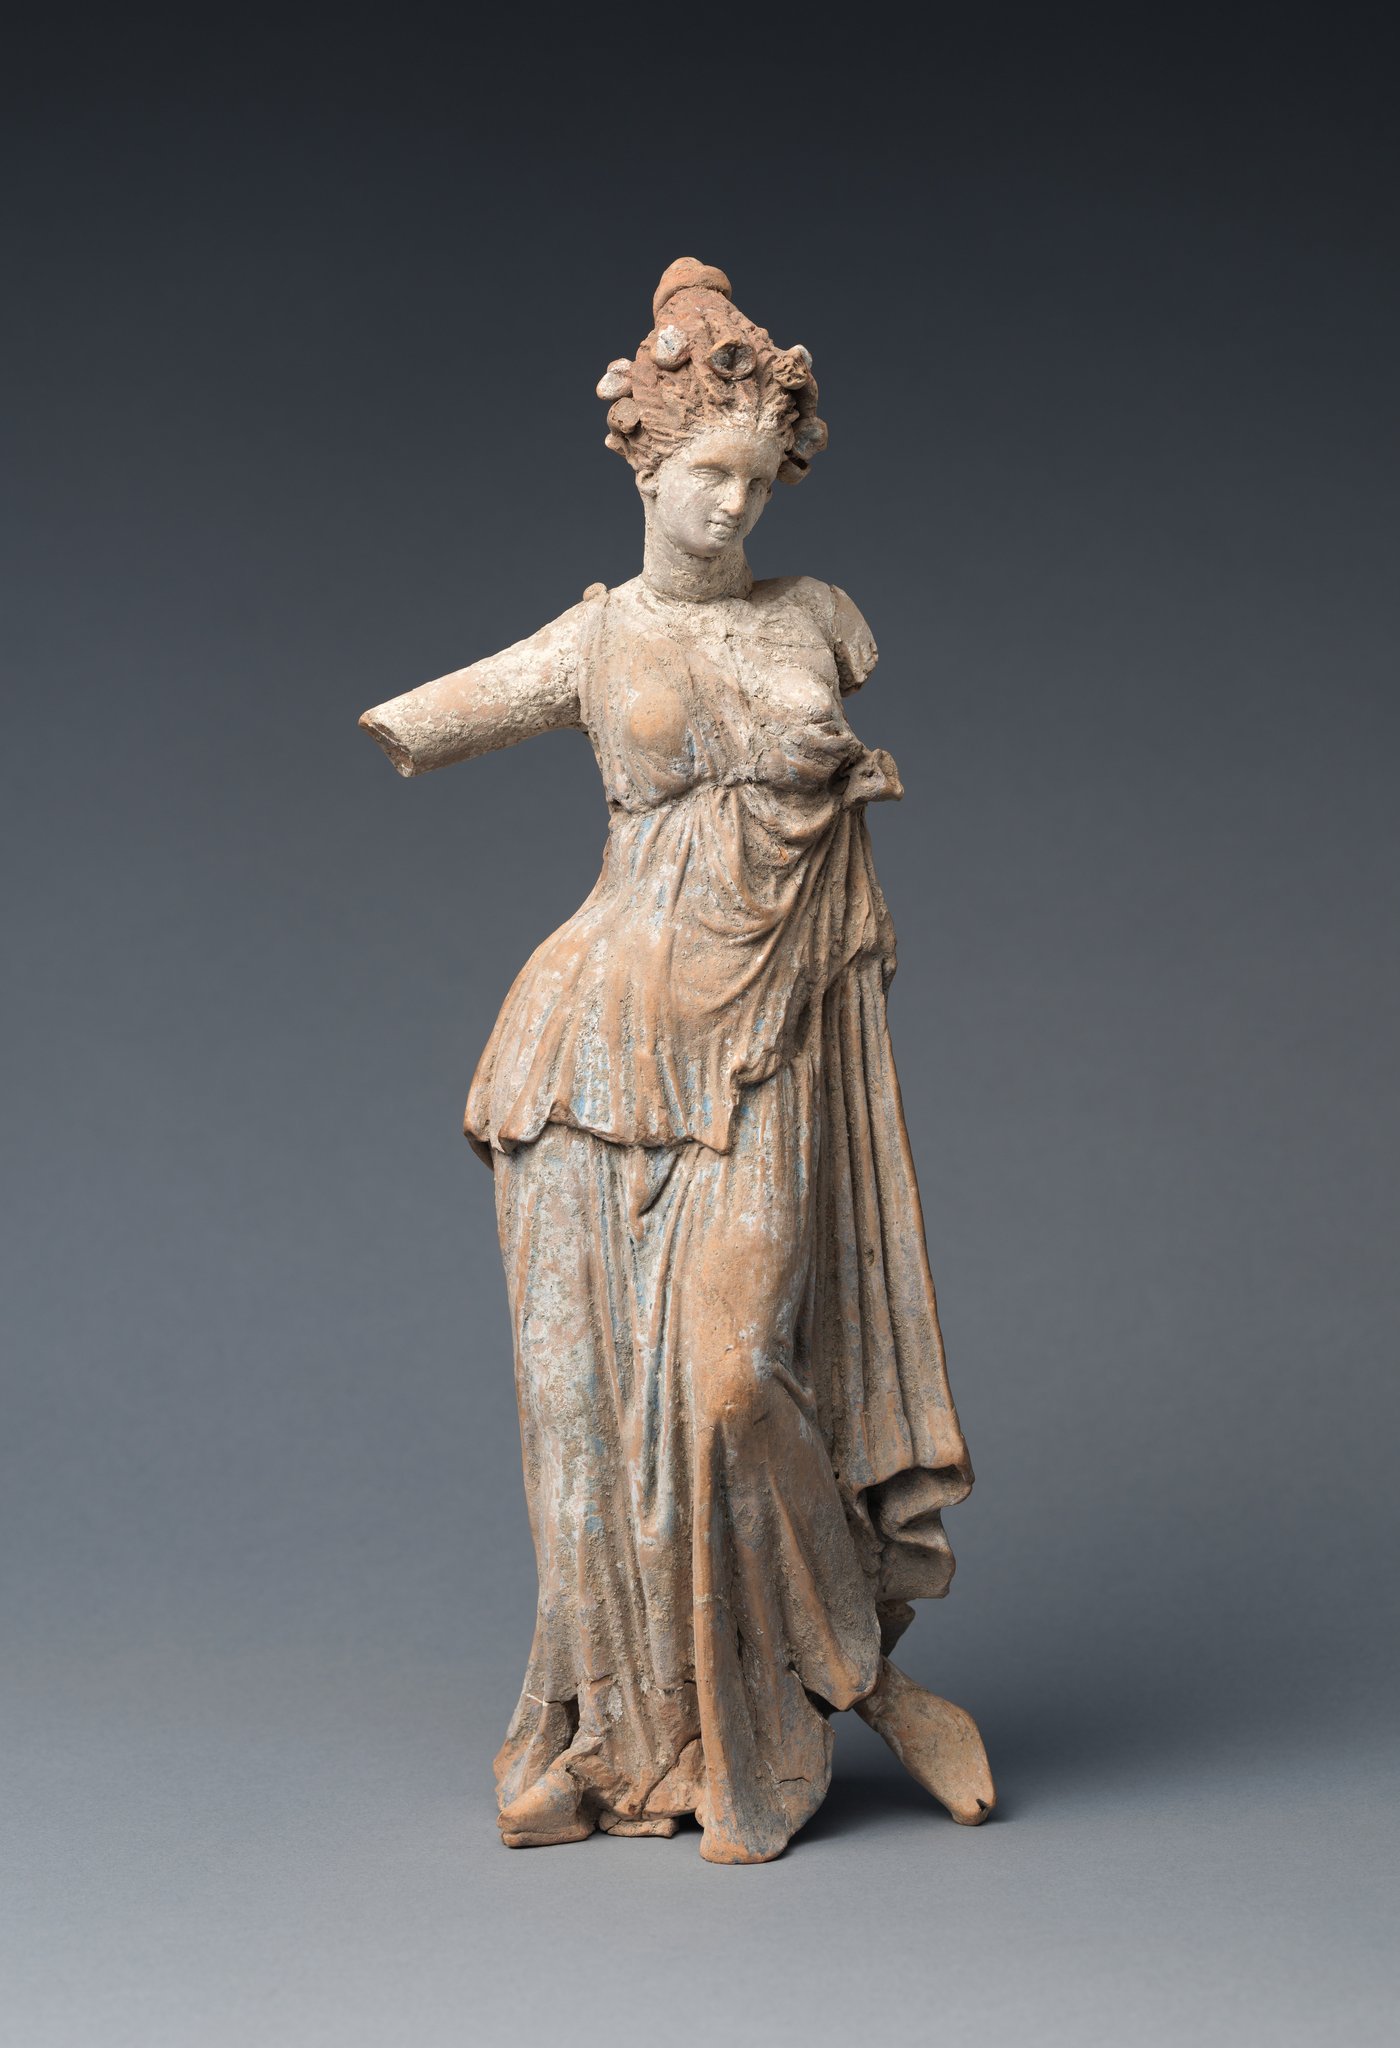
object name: statuette of a woman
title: Terracotta statuette of a woman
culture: greek, south italian, tarentine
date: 234-101 BCE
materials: terracotta